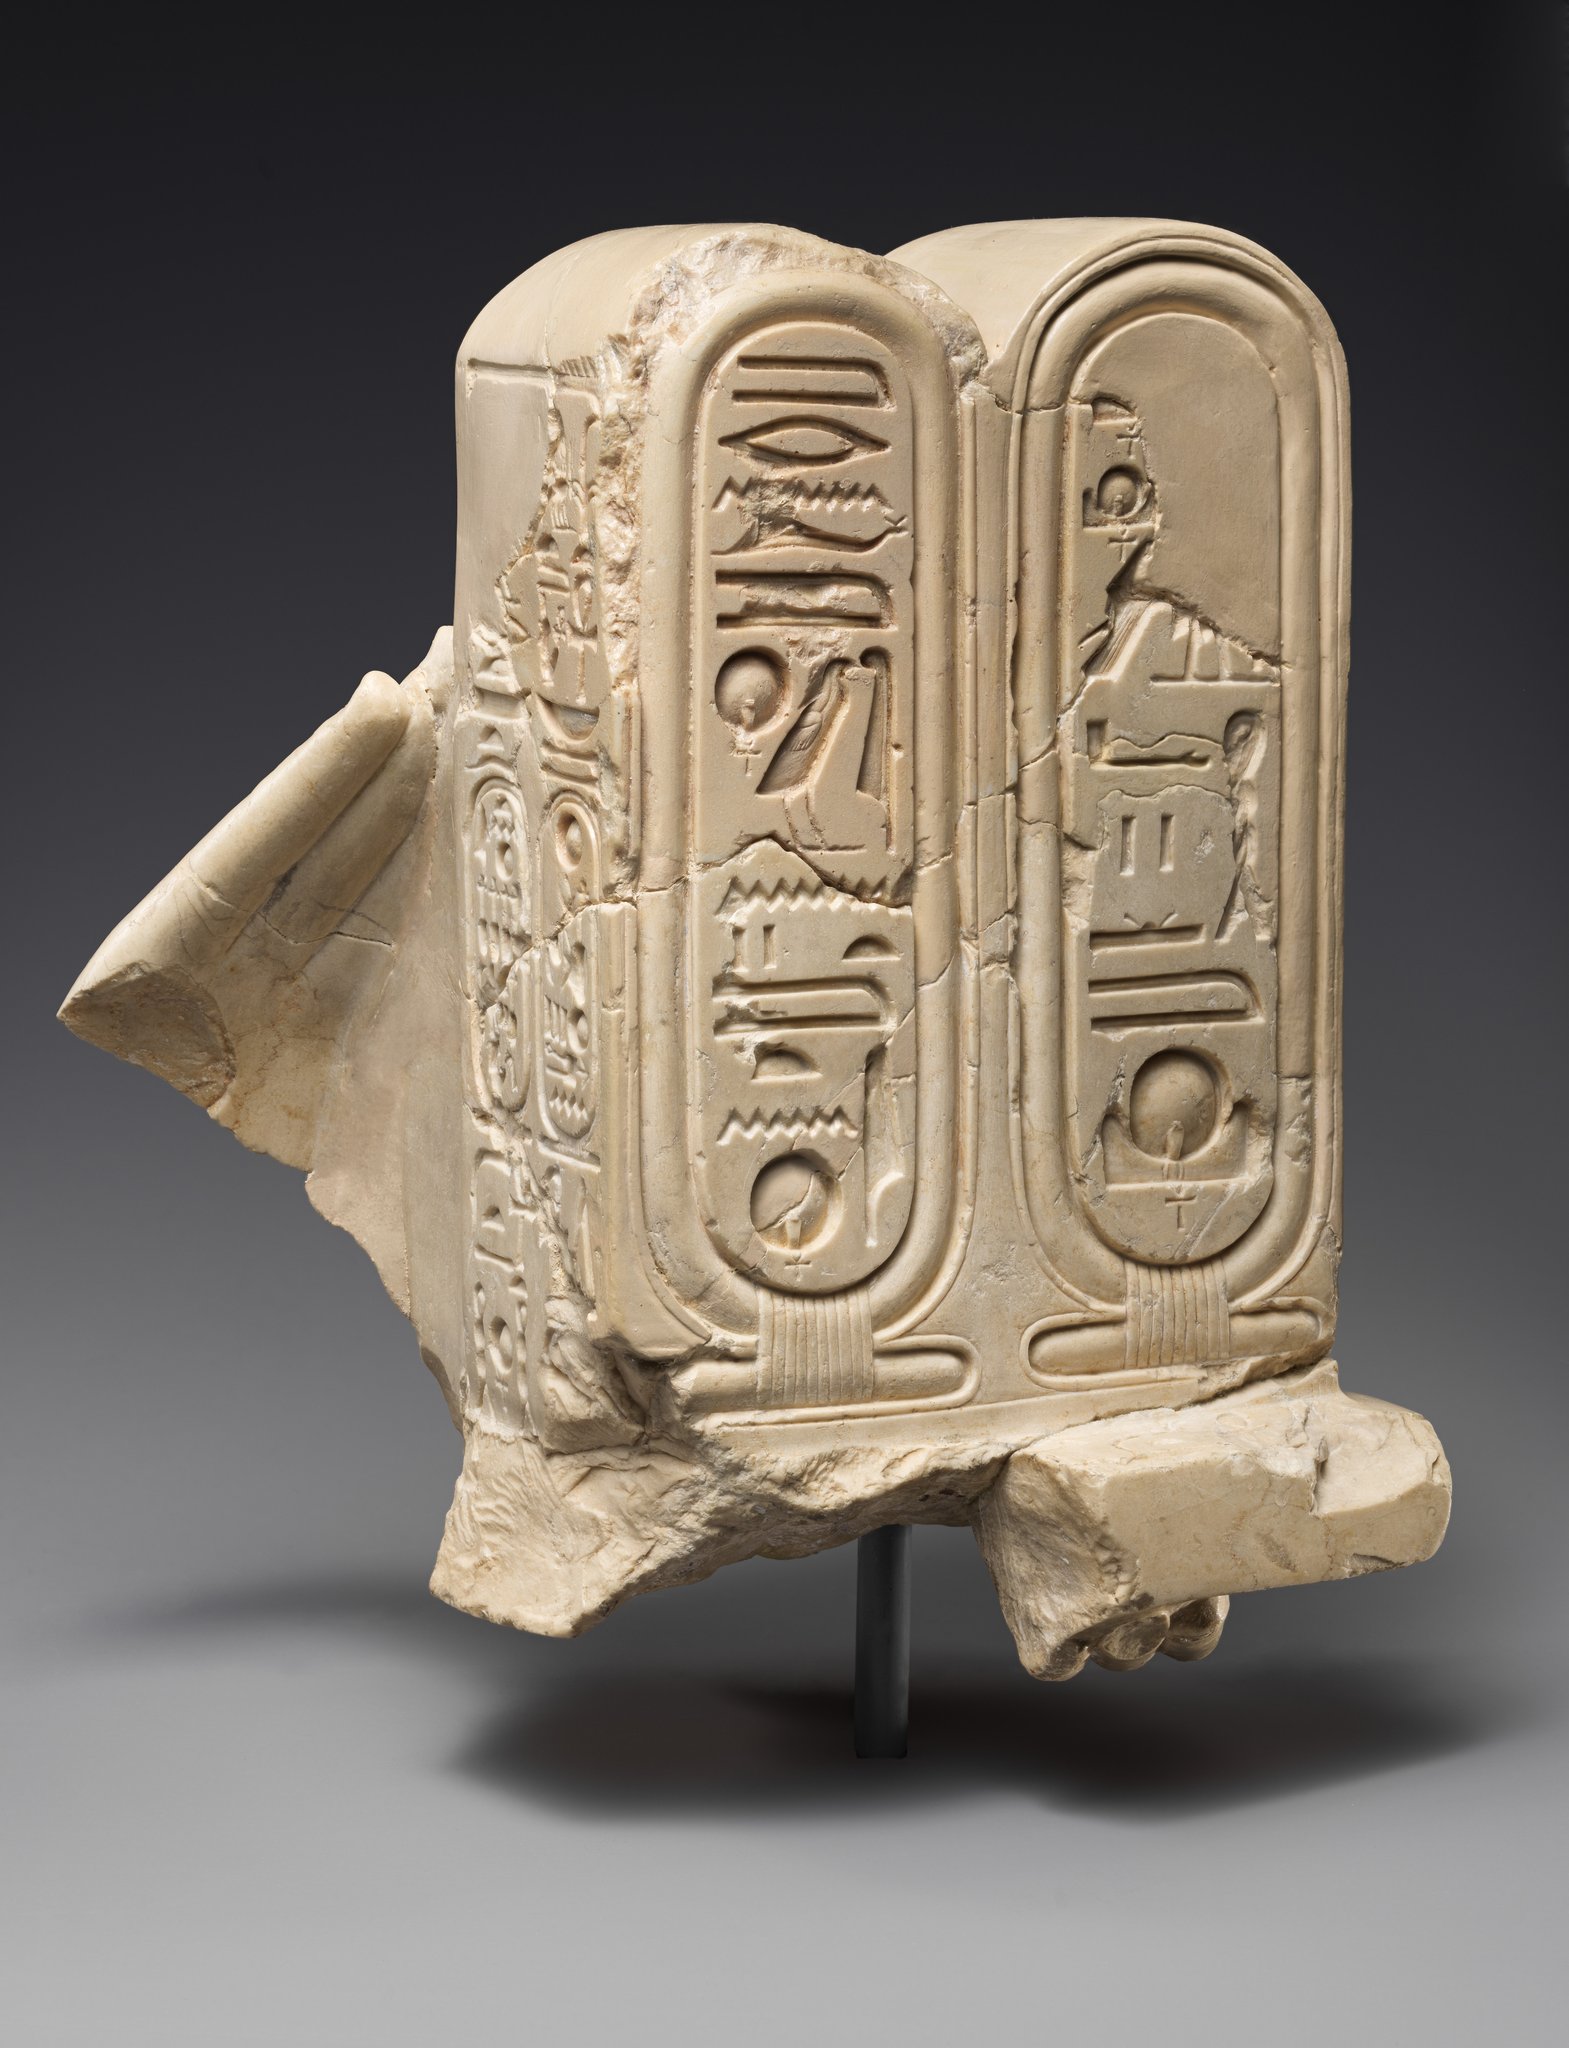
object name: hand offering, aten cartouch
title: Hands offering Aten cartouches (upper part of cartouches are a cast of British Museum EA 58471)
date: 1352-1336 BCE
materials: limestone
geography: egypt